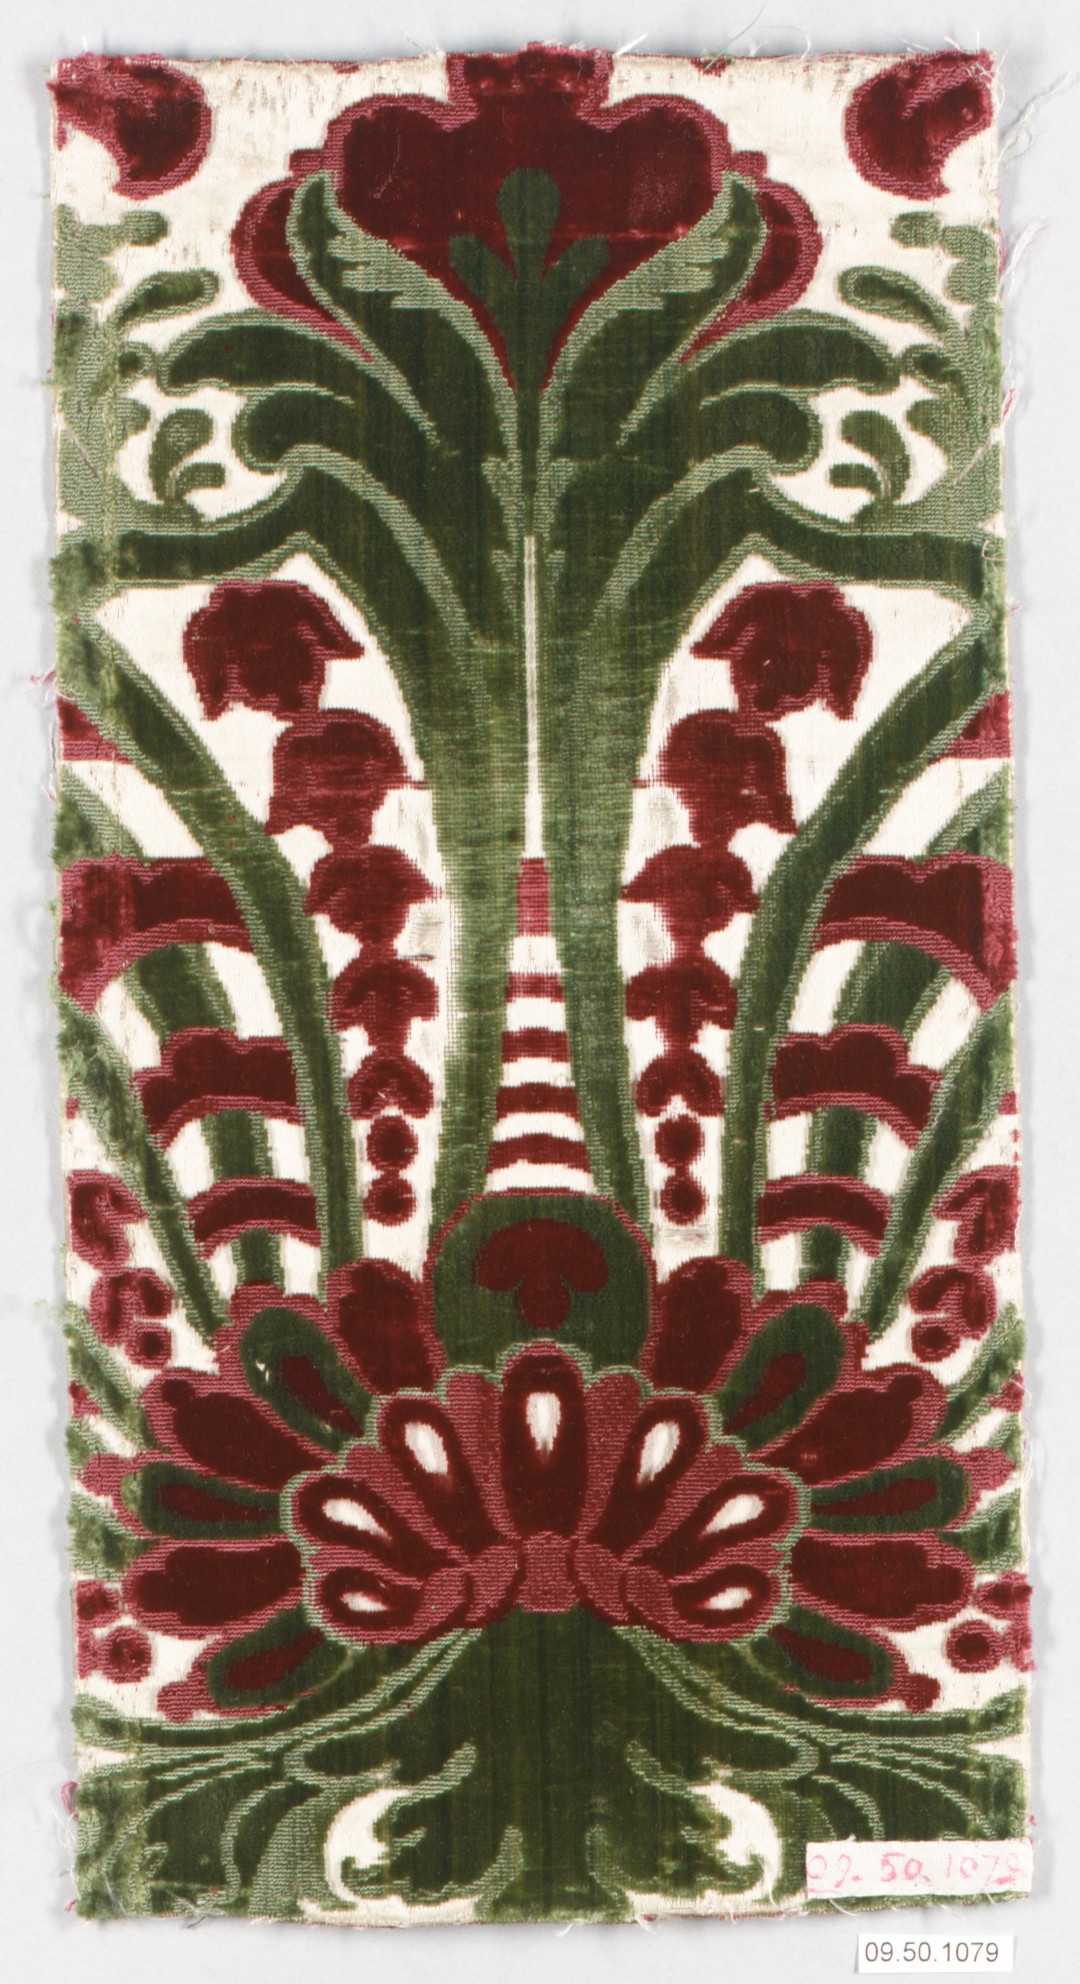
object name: piece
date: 1601-1700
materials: silk